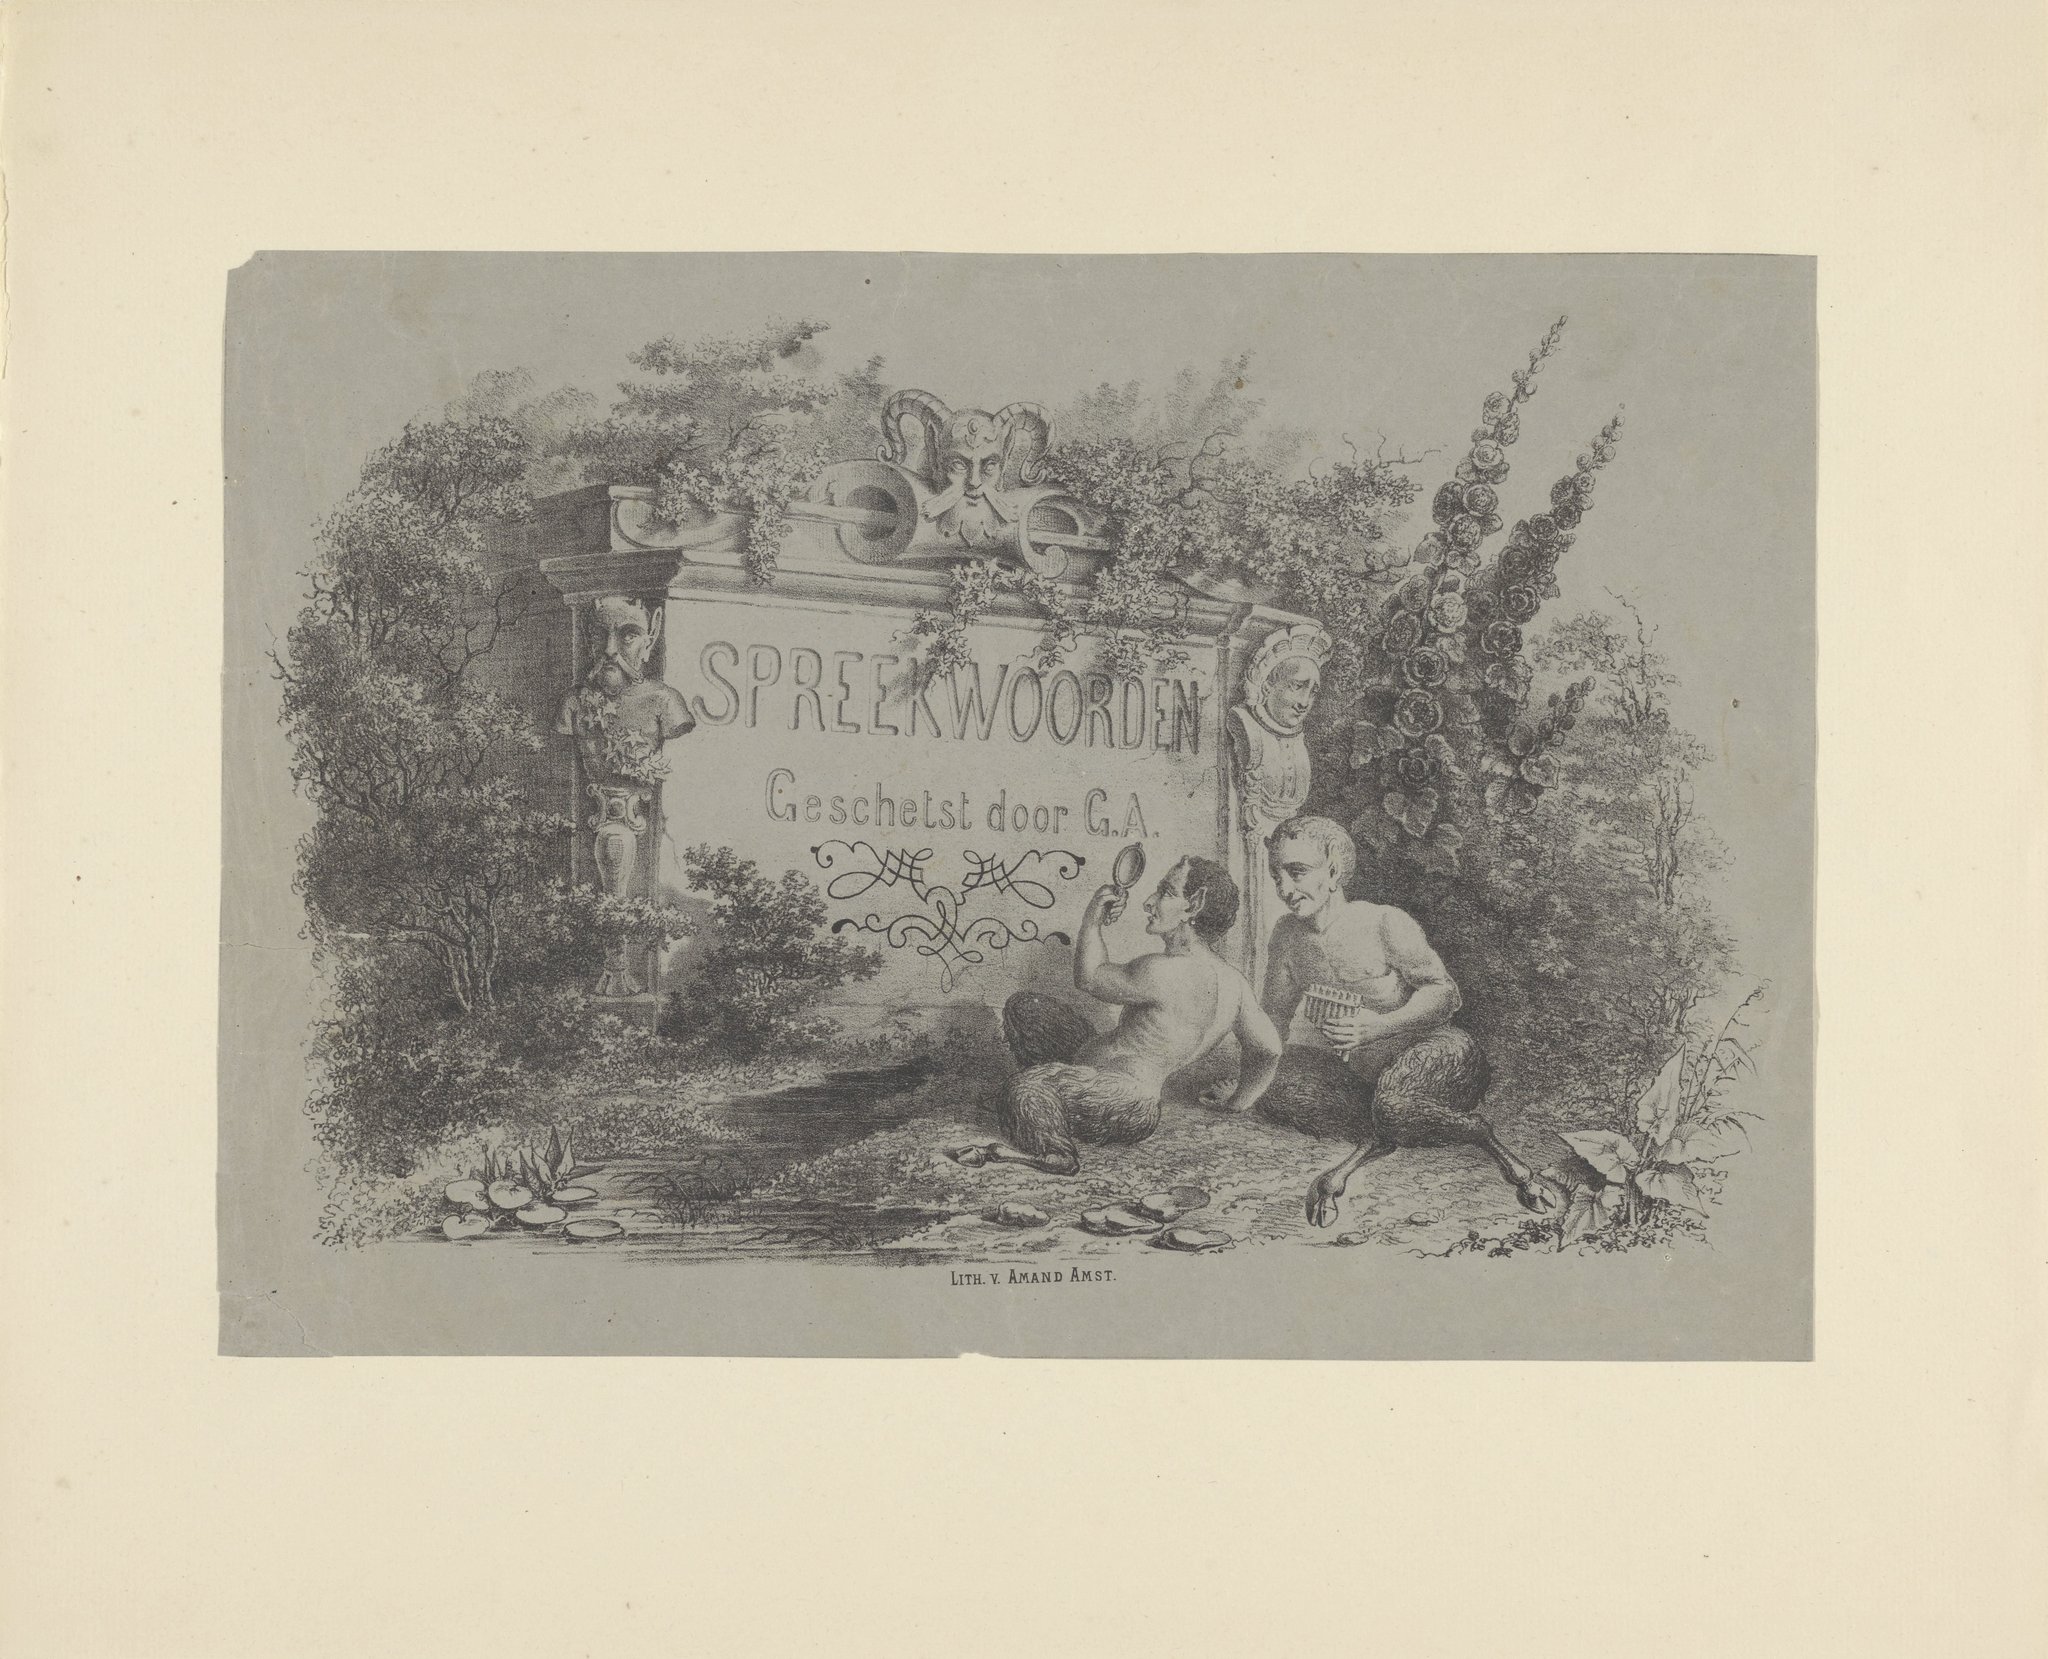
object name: print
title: Titelprent voor: spreekwoorden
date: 1867-1894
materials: paper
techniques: lithograph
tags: herms (garden ornaments), satyr(s) (in general), other memorial structures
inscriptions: collector's mark: Lugt 2228, collector's mark: Lugt 2760, inscription:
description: Een sater leest de tekst op het monument en kijkt door een vergrootglas. De andere sater heeft een panfluit in zijn hand. Het monument is begroeid met planten en gedecoreerd met twee hermen en een gehoornd masker.